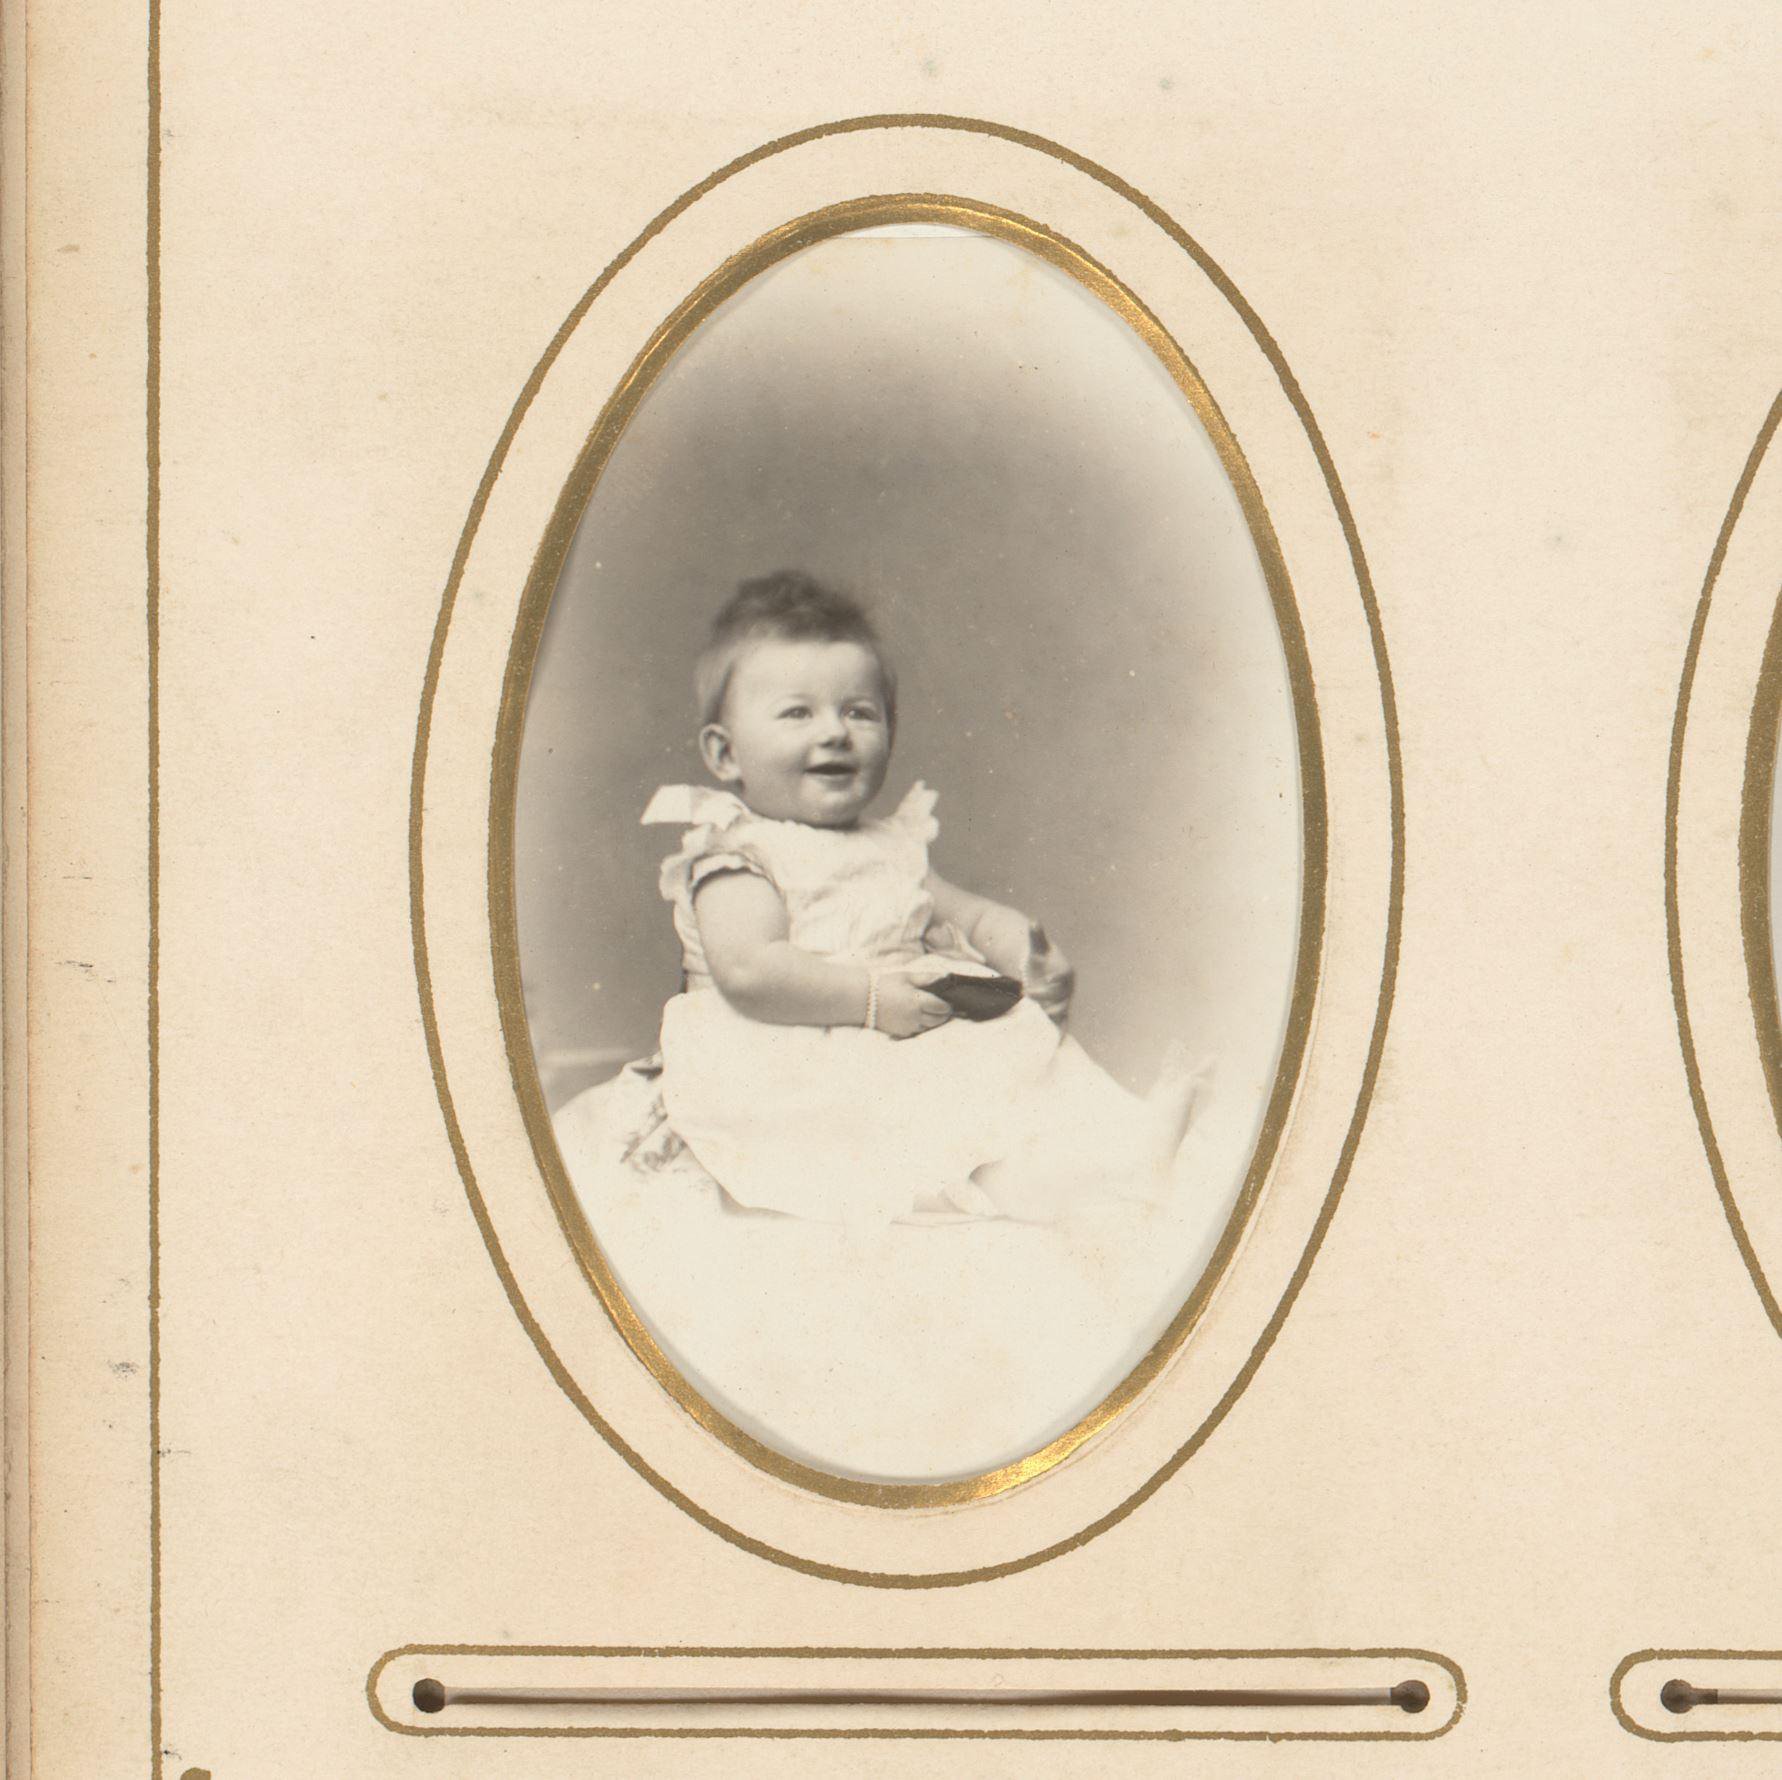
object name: album leaf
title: Portret van een zittende baby, aangeduid als Billy Kesper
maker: f. von pöppinghausen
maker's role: fotograaf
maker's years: 1851-1905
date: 1883-1905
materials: cardboard, photographic support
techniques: matte daylight collodion silver print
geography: rotterdam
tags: sitting figure, historical persons, infant, baby ~ the ages of man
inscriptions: annotation: ‘Billy Kesper/ elf maanden oud’, inscription: ‘F. von Pöppinghausen/ Diergaardelaan 80, Rotterdam.’